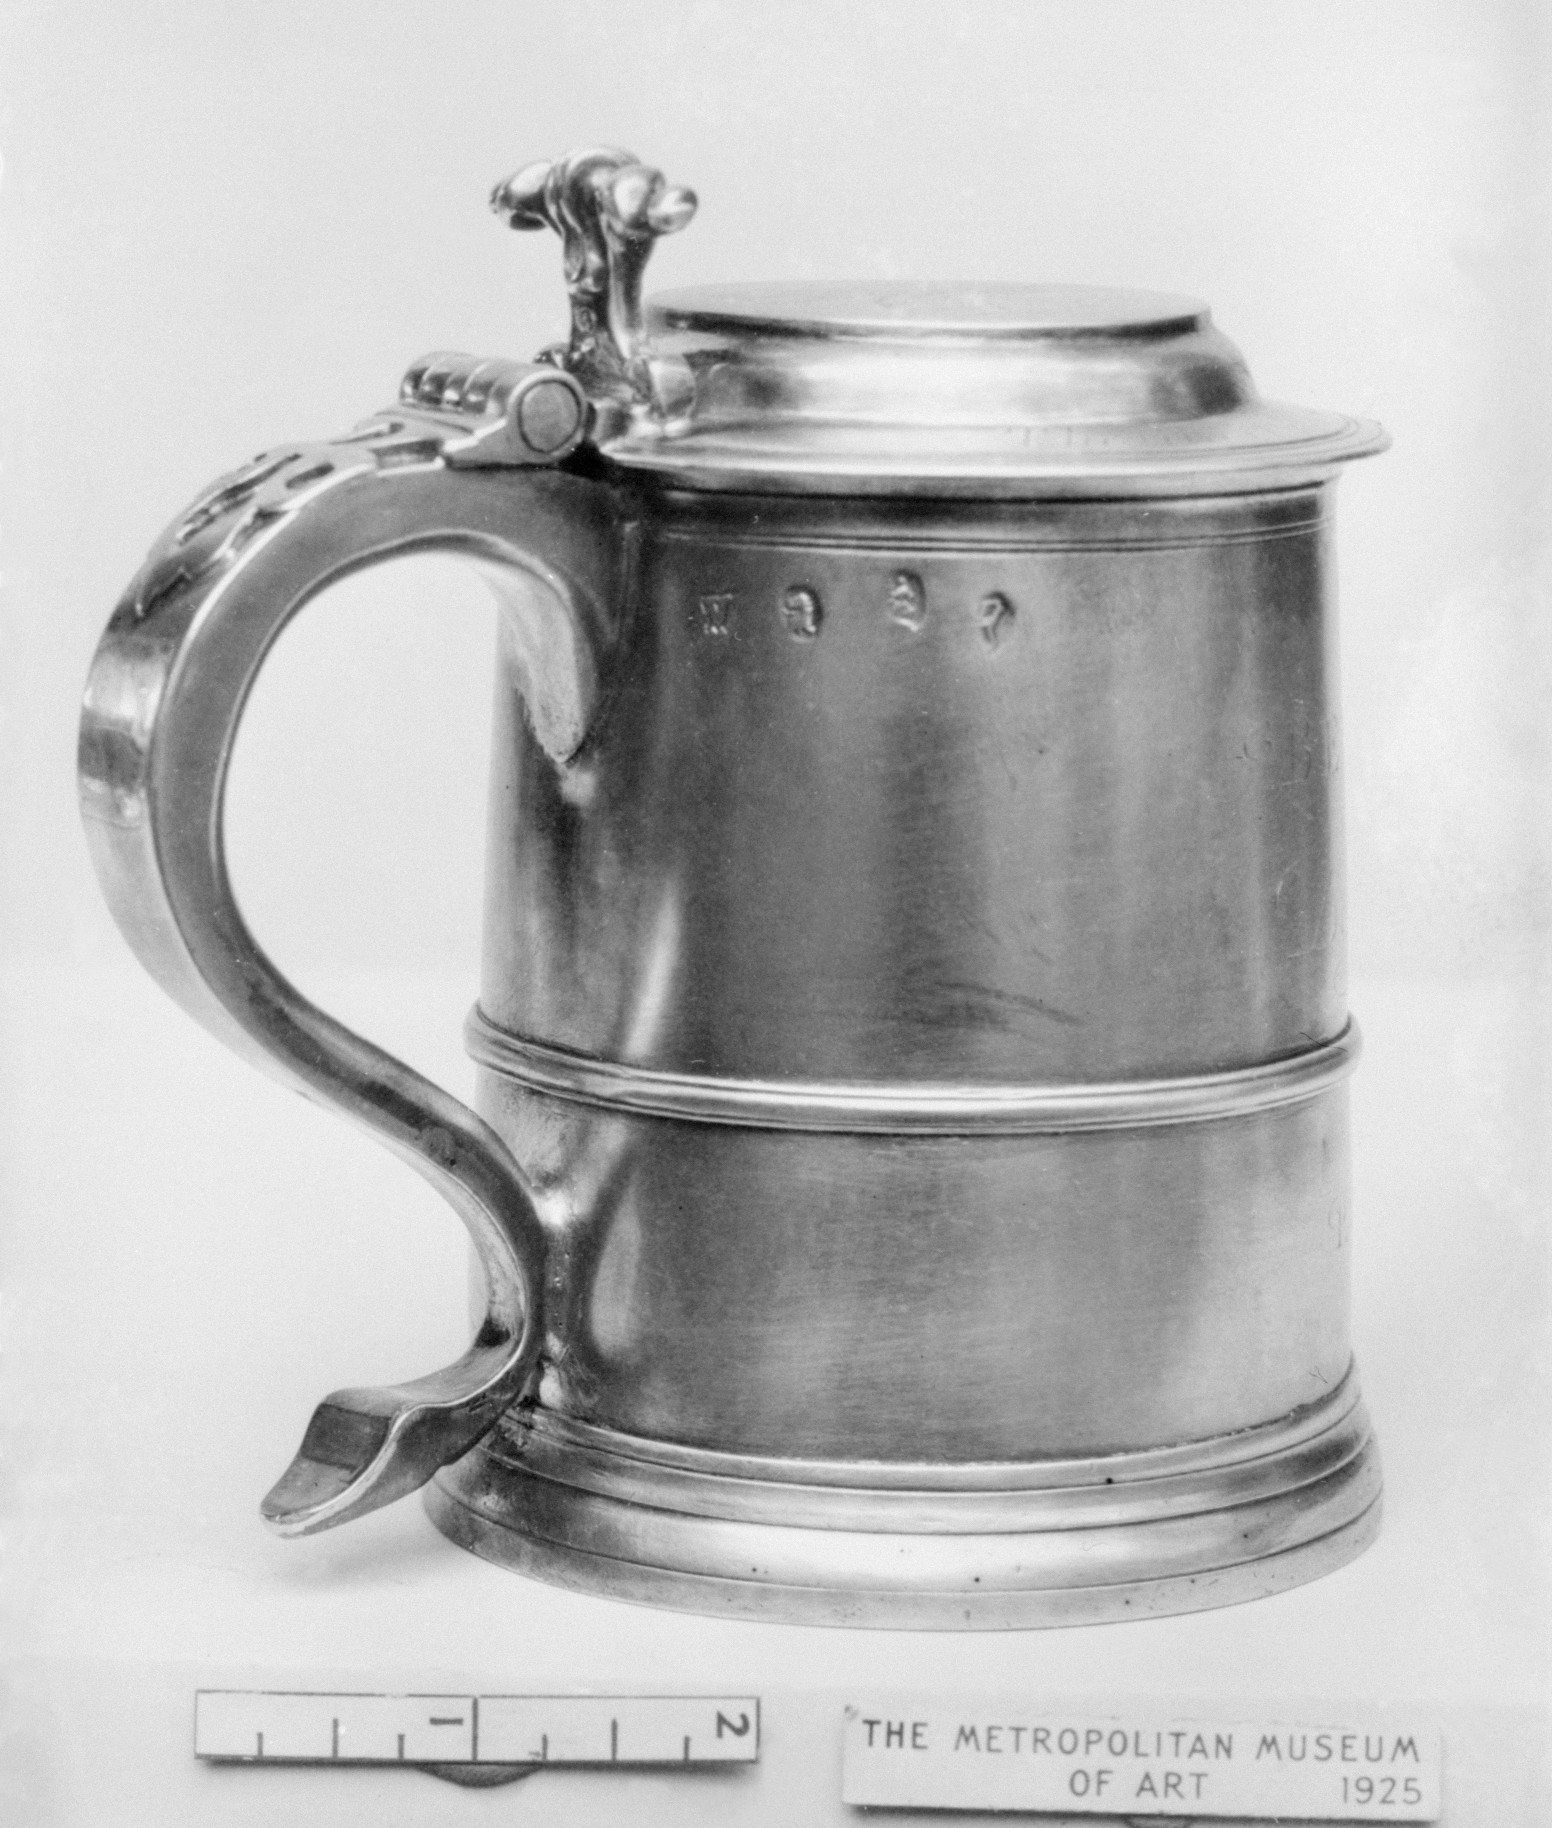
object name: tankard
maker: john wisdom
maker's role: maker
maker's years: 1704-1731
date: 1715-1716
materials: silver